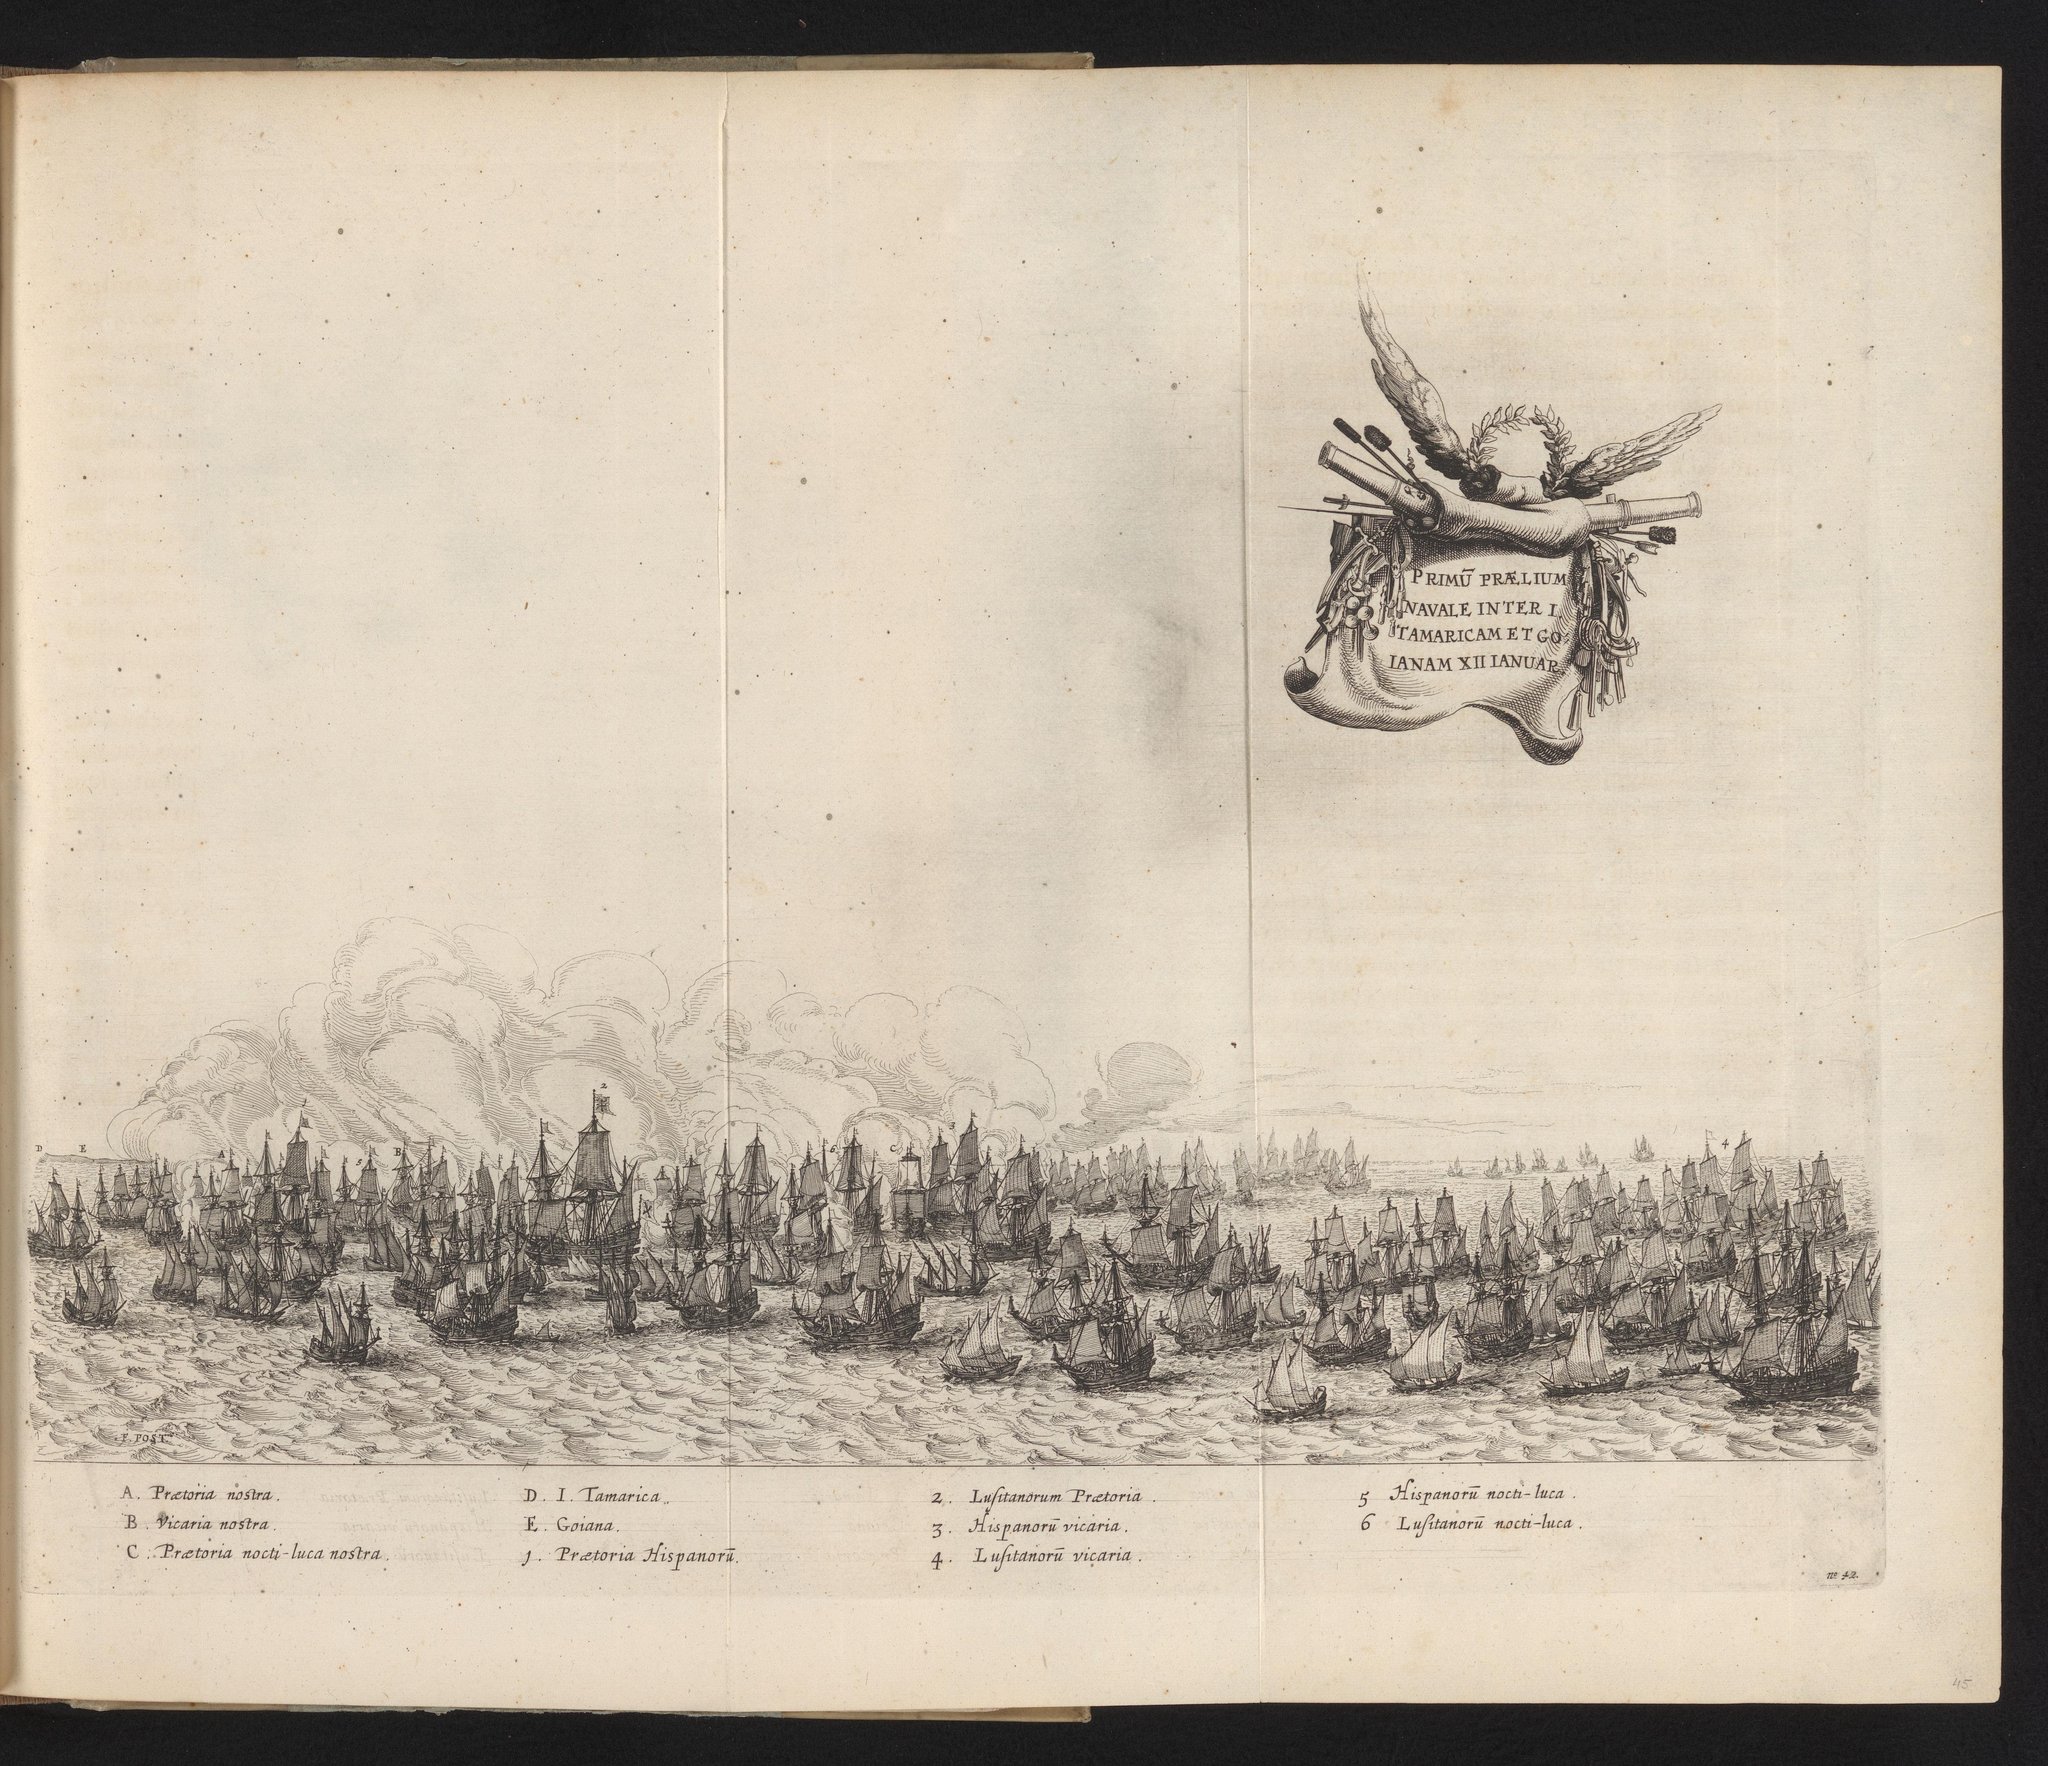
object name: print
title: Eerste gevecht met de Portugese vloot bij Itamaracá, 1640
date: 1645-1647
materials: paper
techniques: etching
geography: amsterdam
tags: johan maurits graaf van nassau-siegen, battle (+ naval force)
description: Eerste gevecht tussen de vloot van de WIC onder Willem Cornelisz. Loos met de Portugese vloot onder graaf de la Torre bij het eiland Itamaracá, voor de kust van Brazilië, 12 januari 1640. In de lucht een gevleugelde banderol met de titel en de wapens. In het onderschrift de verklaring van de letters A-E en de cijfers 1-6 in het Latijn. Plaat nr. 42 in een serie van 55 voorstellingen van de tocht naar en het verblijf in Brazilië van graaf Johan Maurits van Nassau in de jaren 1636-1644.